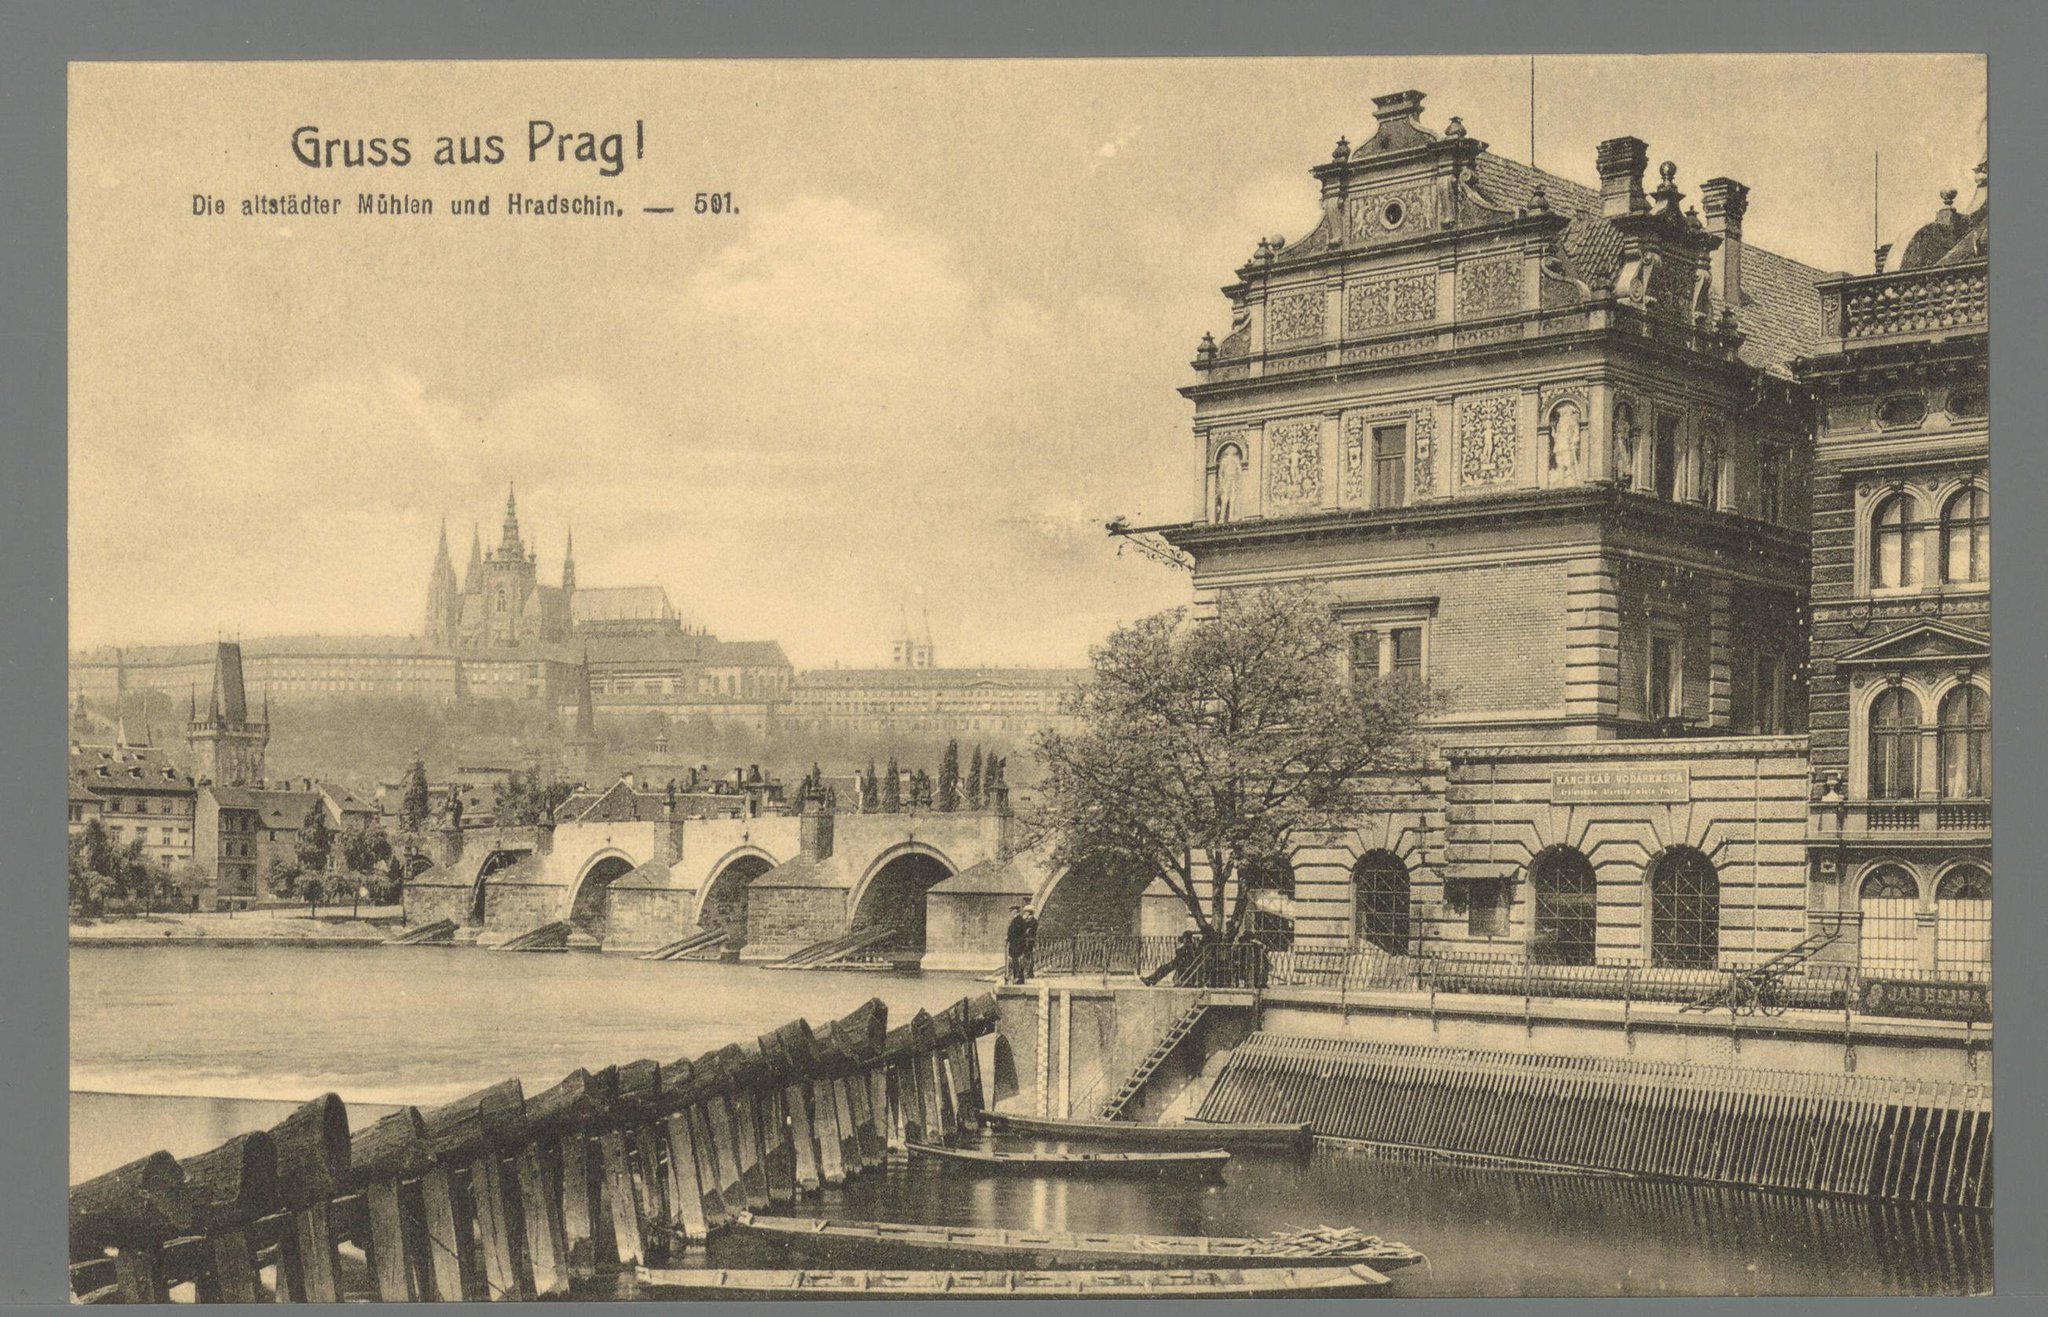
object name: ansichtkaart, prentbriefkaart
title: Gruss aus Prag! Die altstädter Mühlen und Hradschin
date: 1908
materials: cardboard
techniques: photograph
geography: prague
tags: castle, windmill in landscape, canals, waters (in city)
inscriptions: date